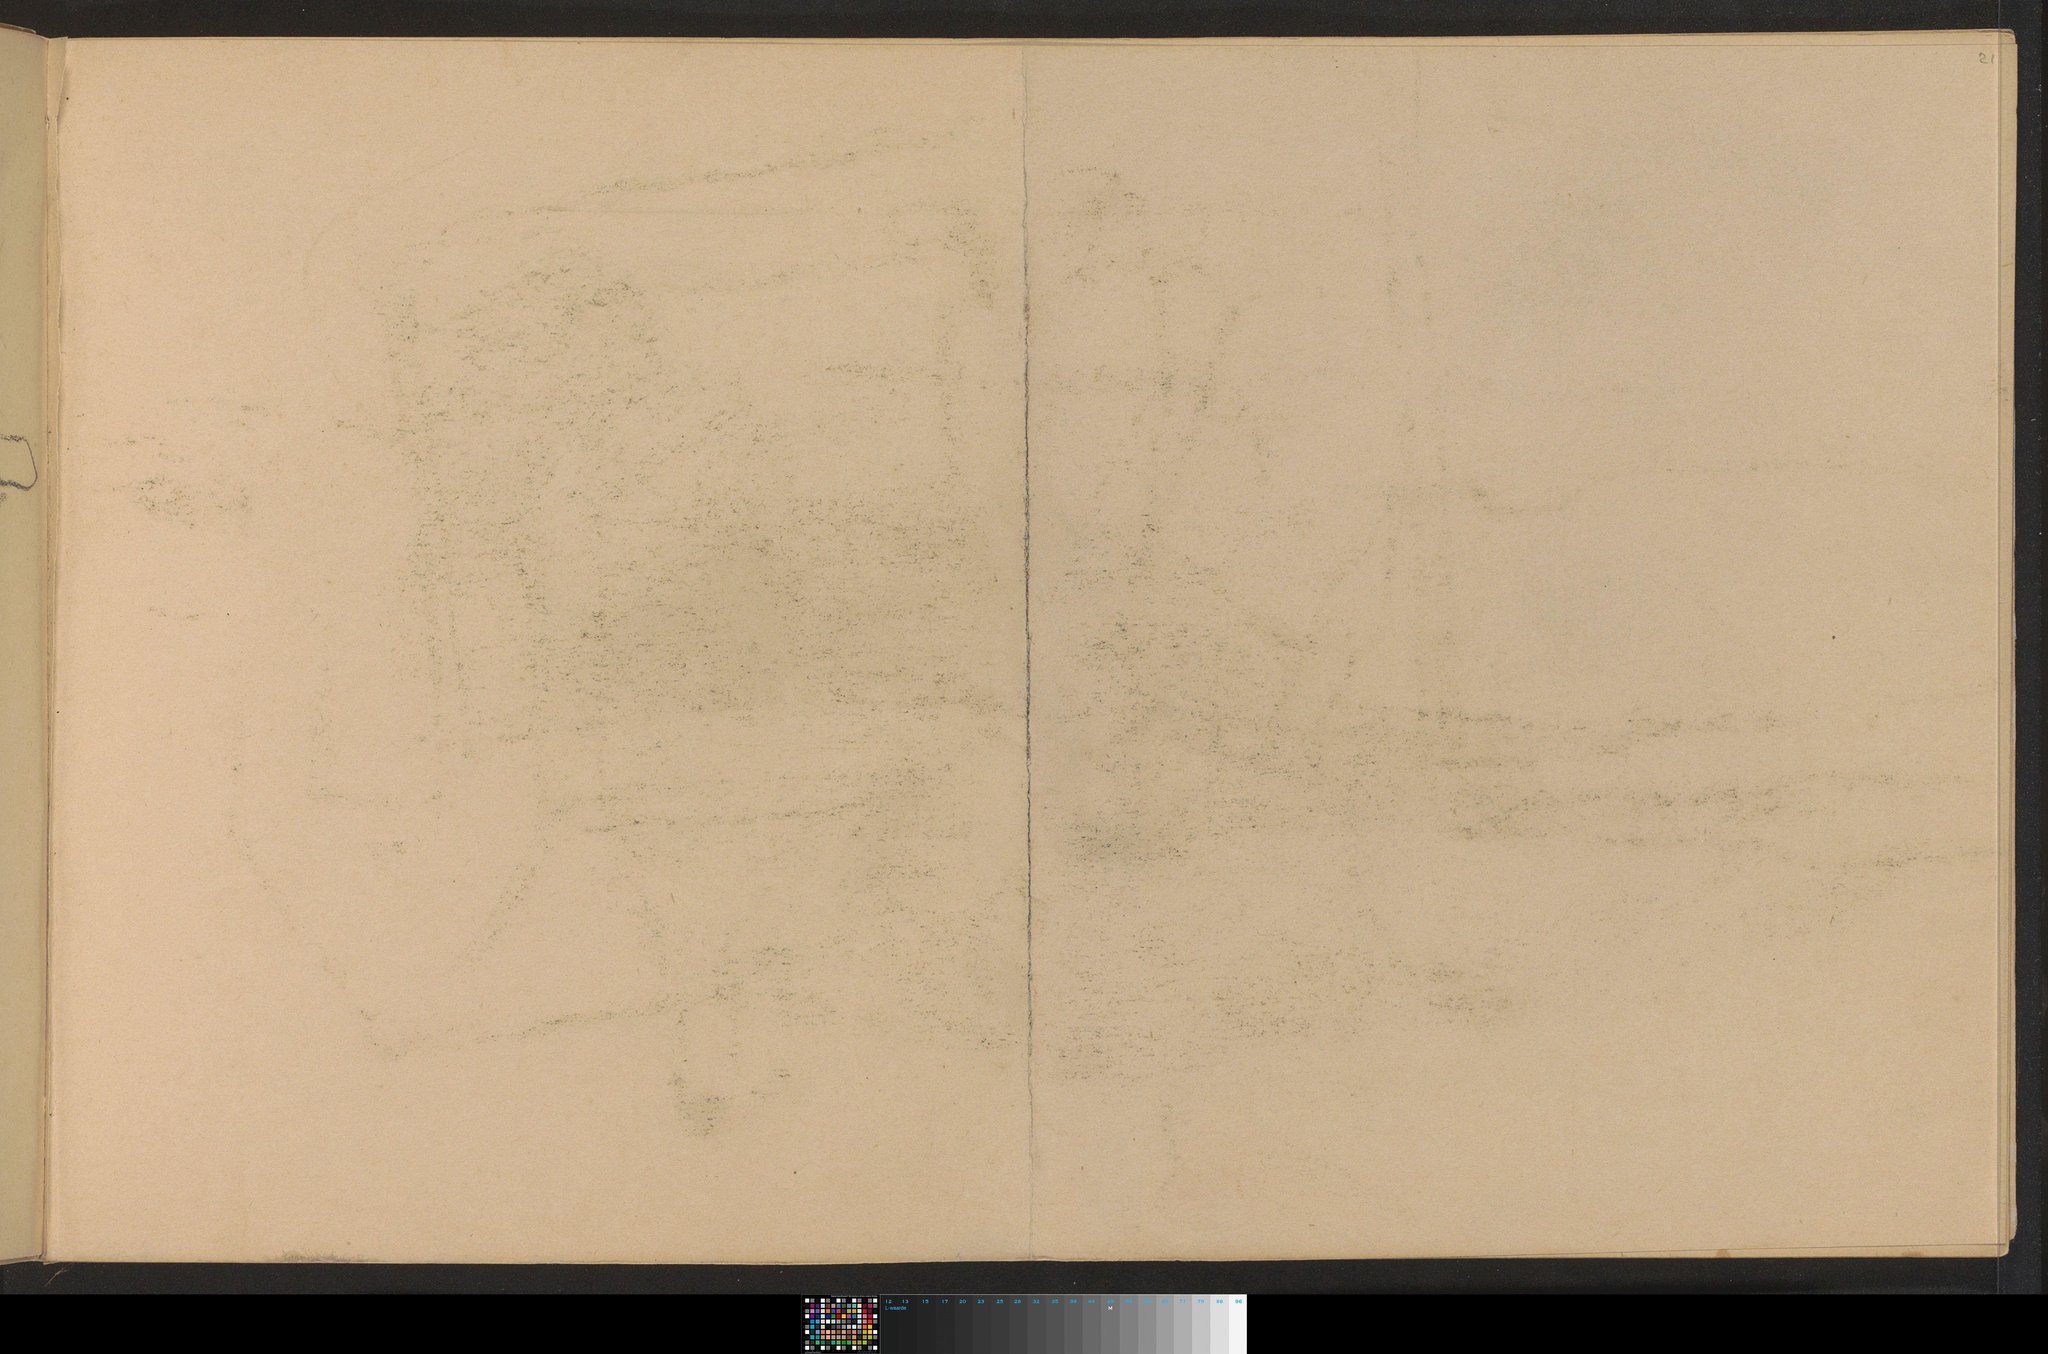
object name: sketchbook leaf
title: Abklatsch van de krijttekening op pagina 20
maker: willem witsen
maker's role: draughtsman, painter, print maker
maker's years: 1860-1923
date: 1897-1910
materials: paper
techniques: printmaking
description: In het midden een vouw die met zwart krijt is overgetrokken. Pagina 21 uit een schetsboek met 19 bladen.